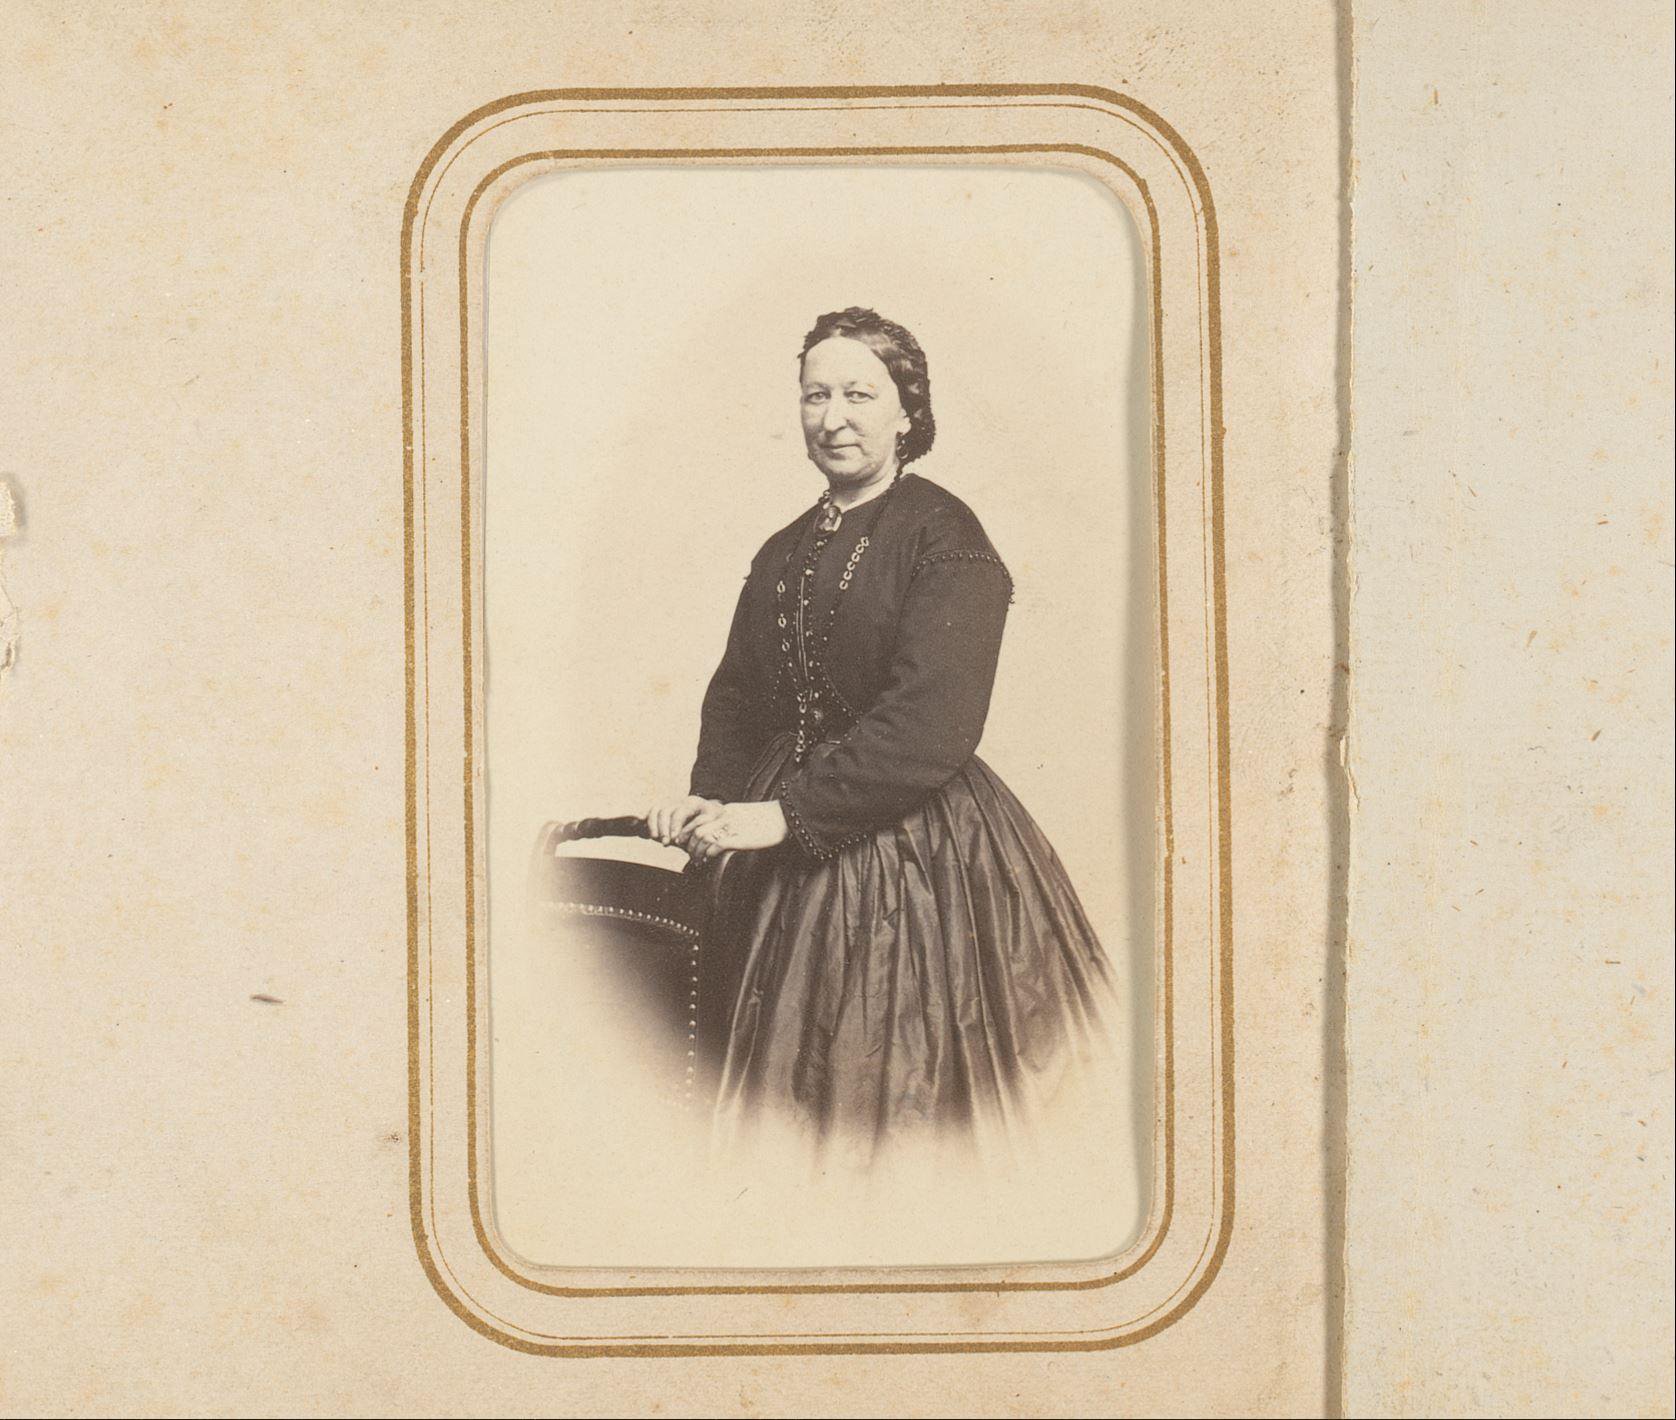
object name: album leaf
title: Portret van een vrouw, staand bij een stoel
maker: antonius godefridus schull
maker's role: fotograaf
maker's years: 1819-1896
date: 1860-1885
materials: cardboard, photographic support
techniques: albumen print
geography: den bosch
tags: historical persons - bb - woman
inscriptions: inscription: ‘A.G. Schull/ Kunstschilder/ 's Bosch/ Kerkstraat’